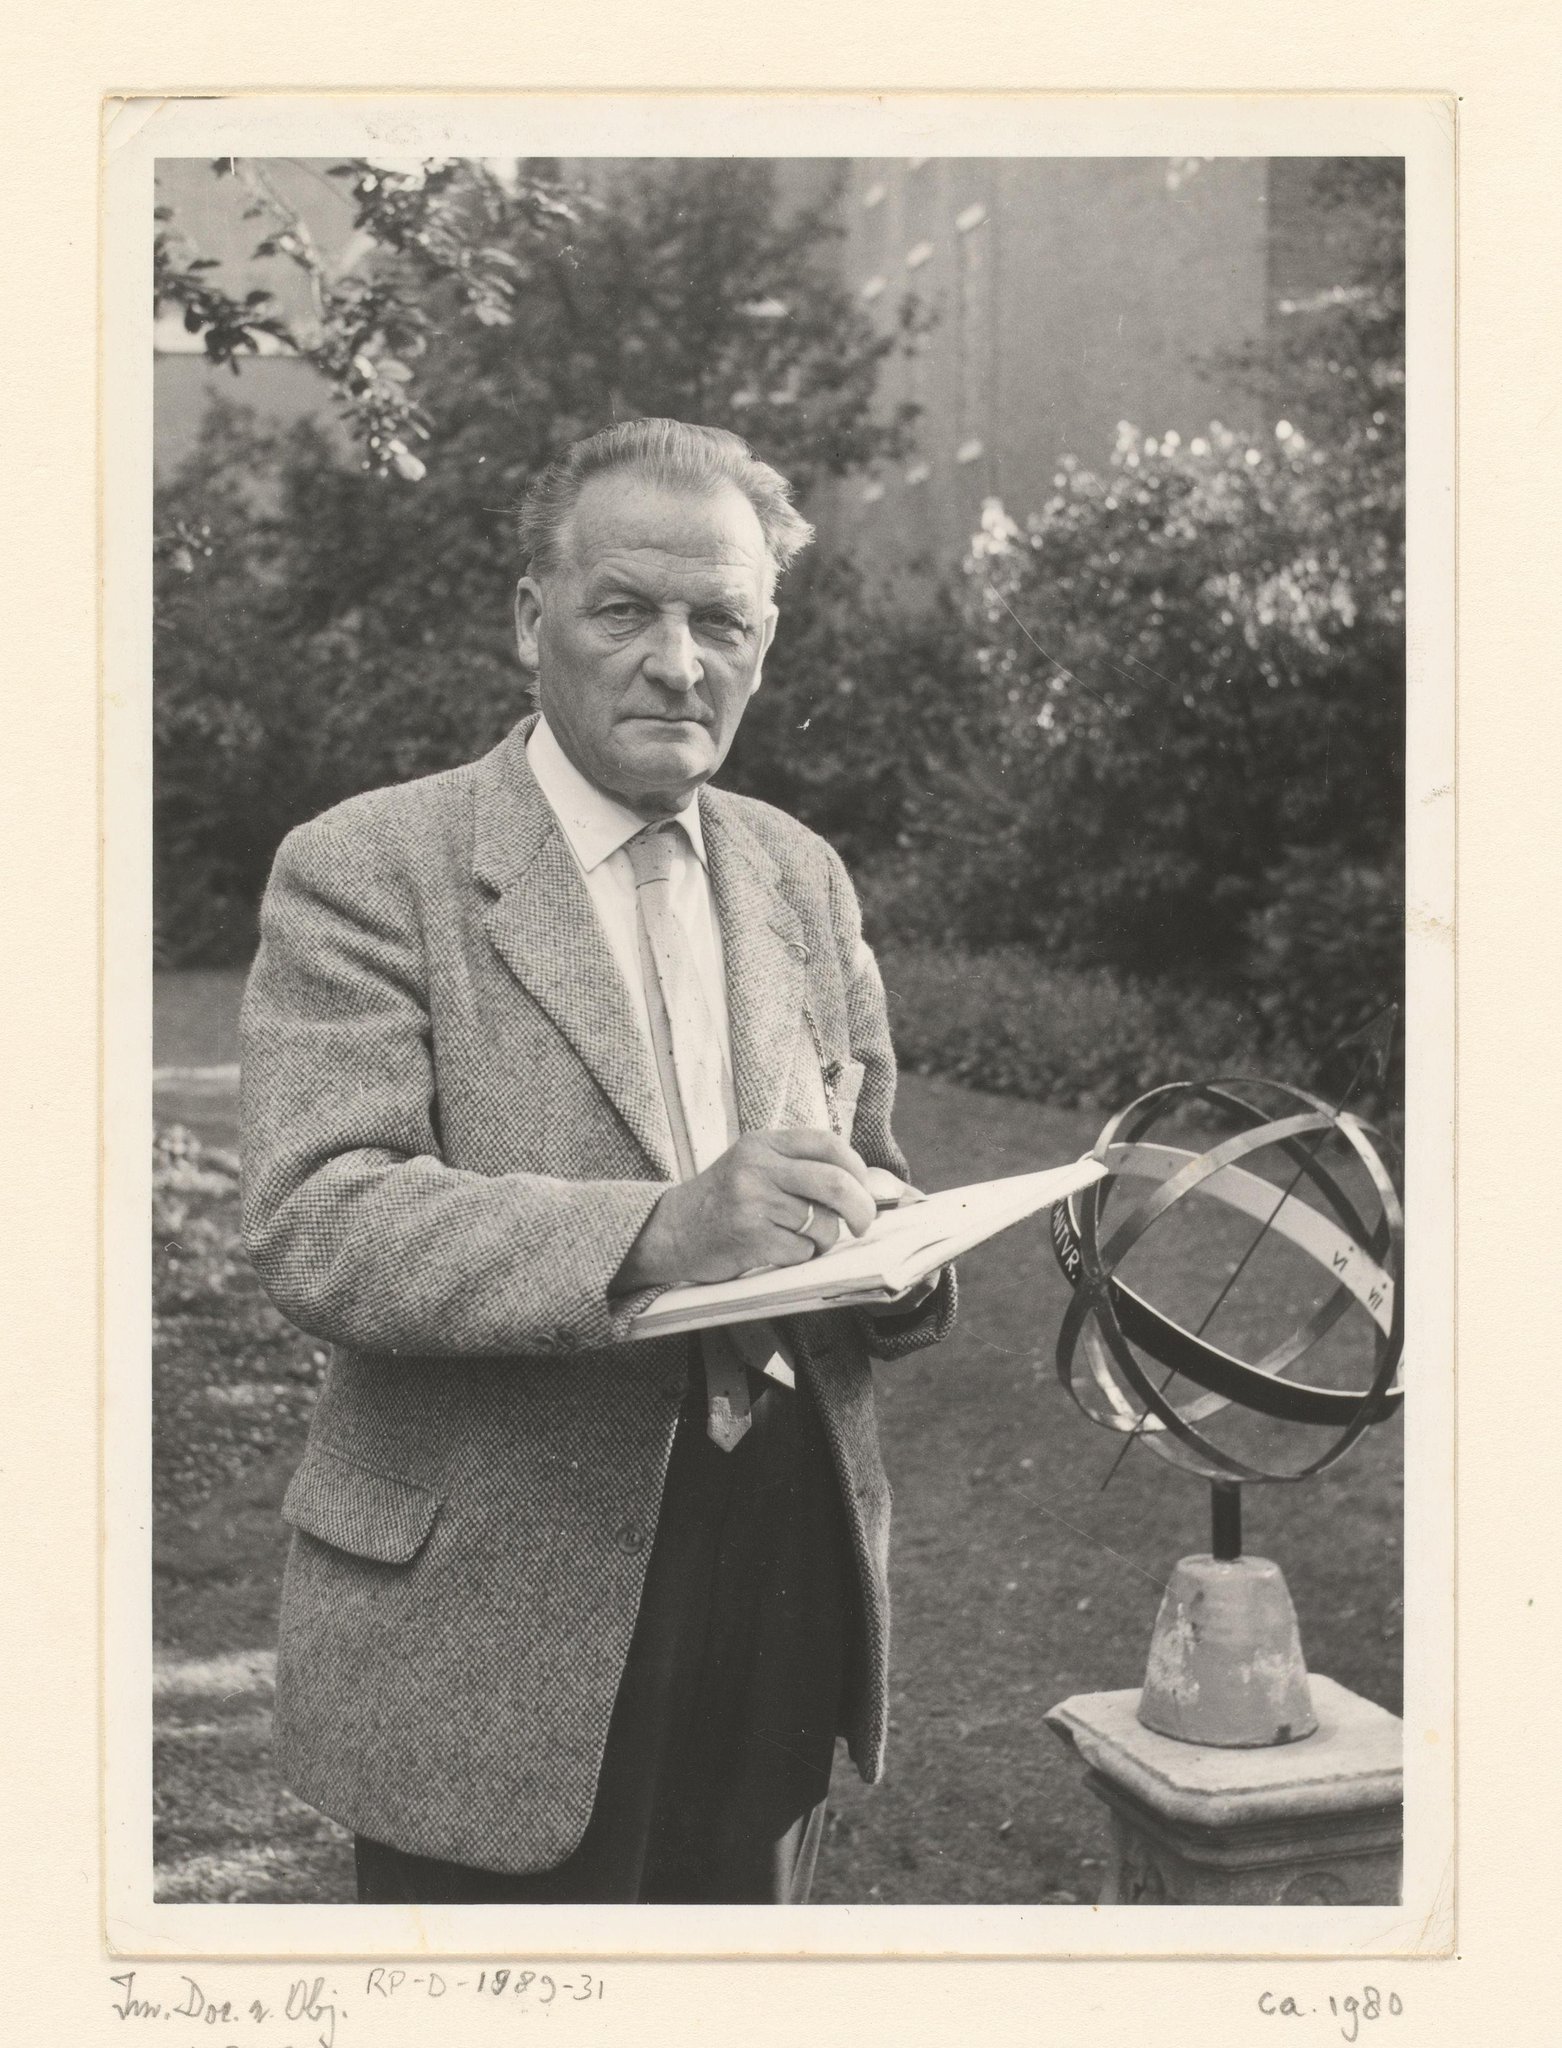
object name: photograph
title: Portret van Sjoerd Kuperus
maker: Anonymous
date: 1980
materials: paper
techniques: gelatin silver print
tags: print maker, draughtsman, sjoerd kuperus, historical persons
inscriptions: copyright notice: ‘Copyright Leeuwarder Courant’